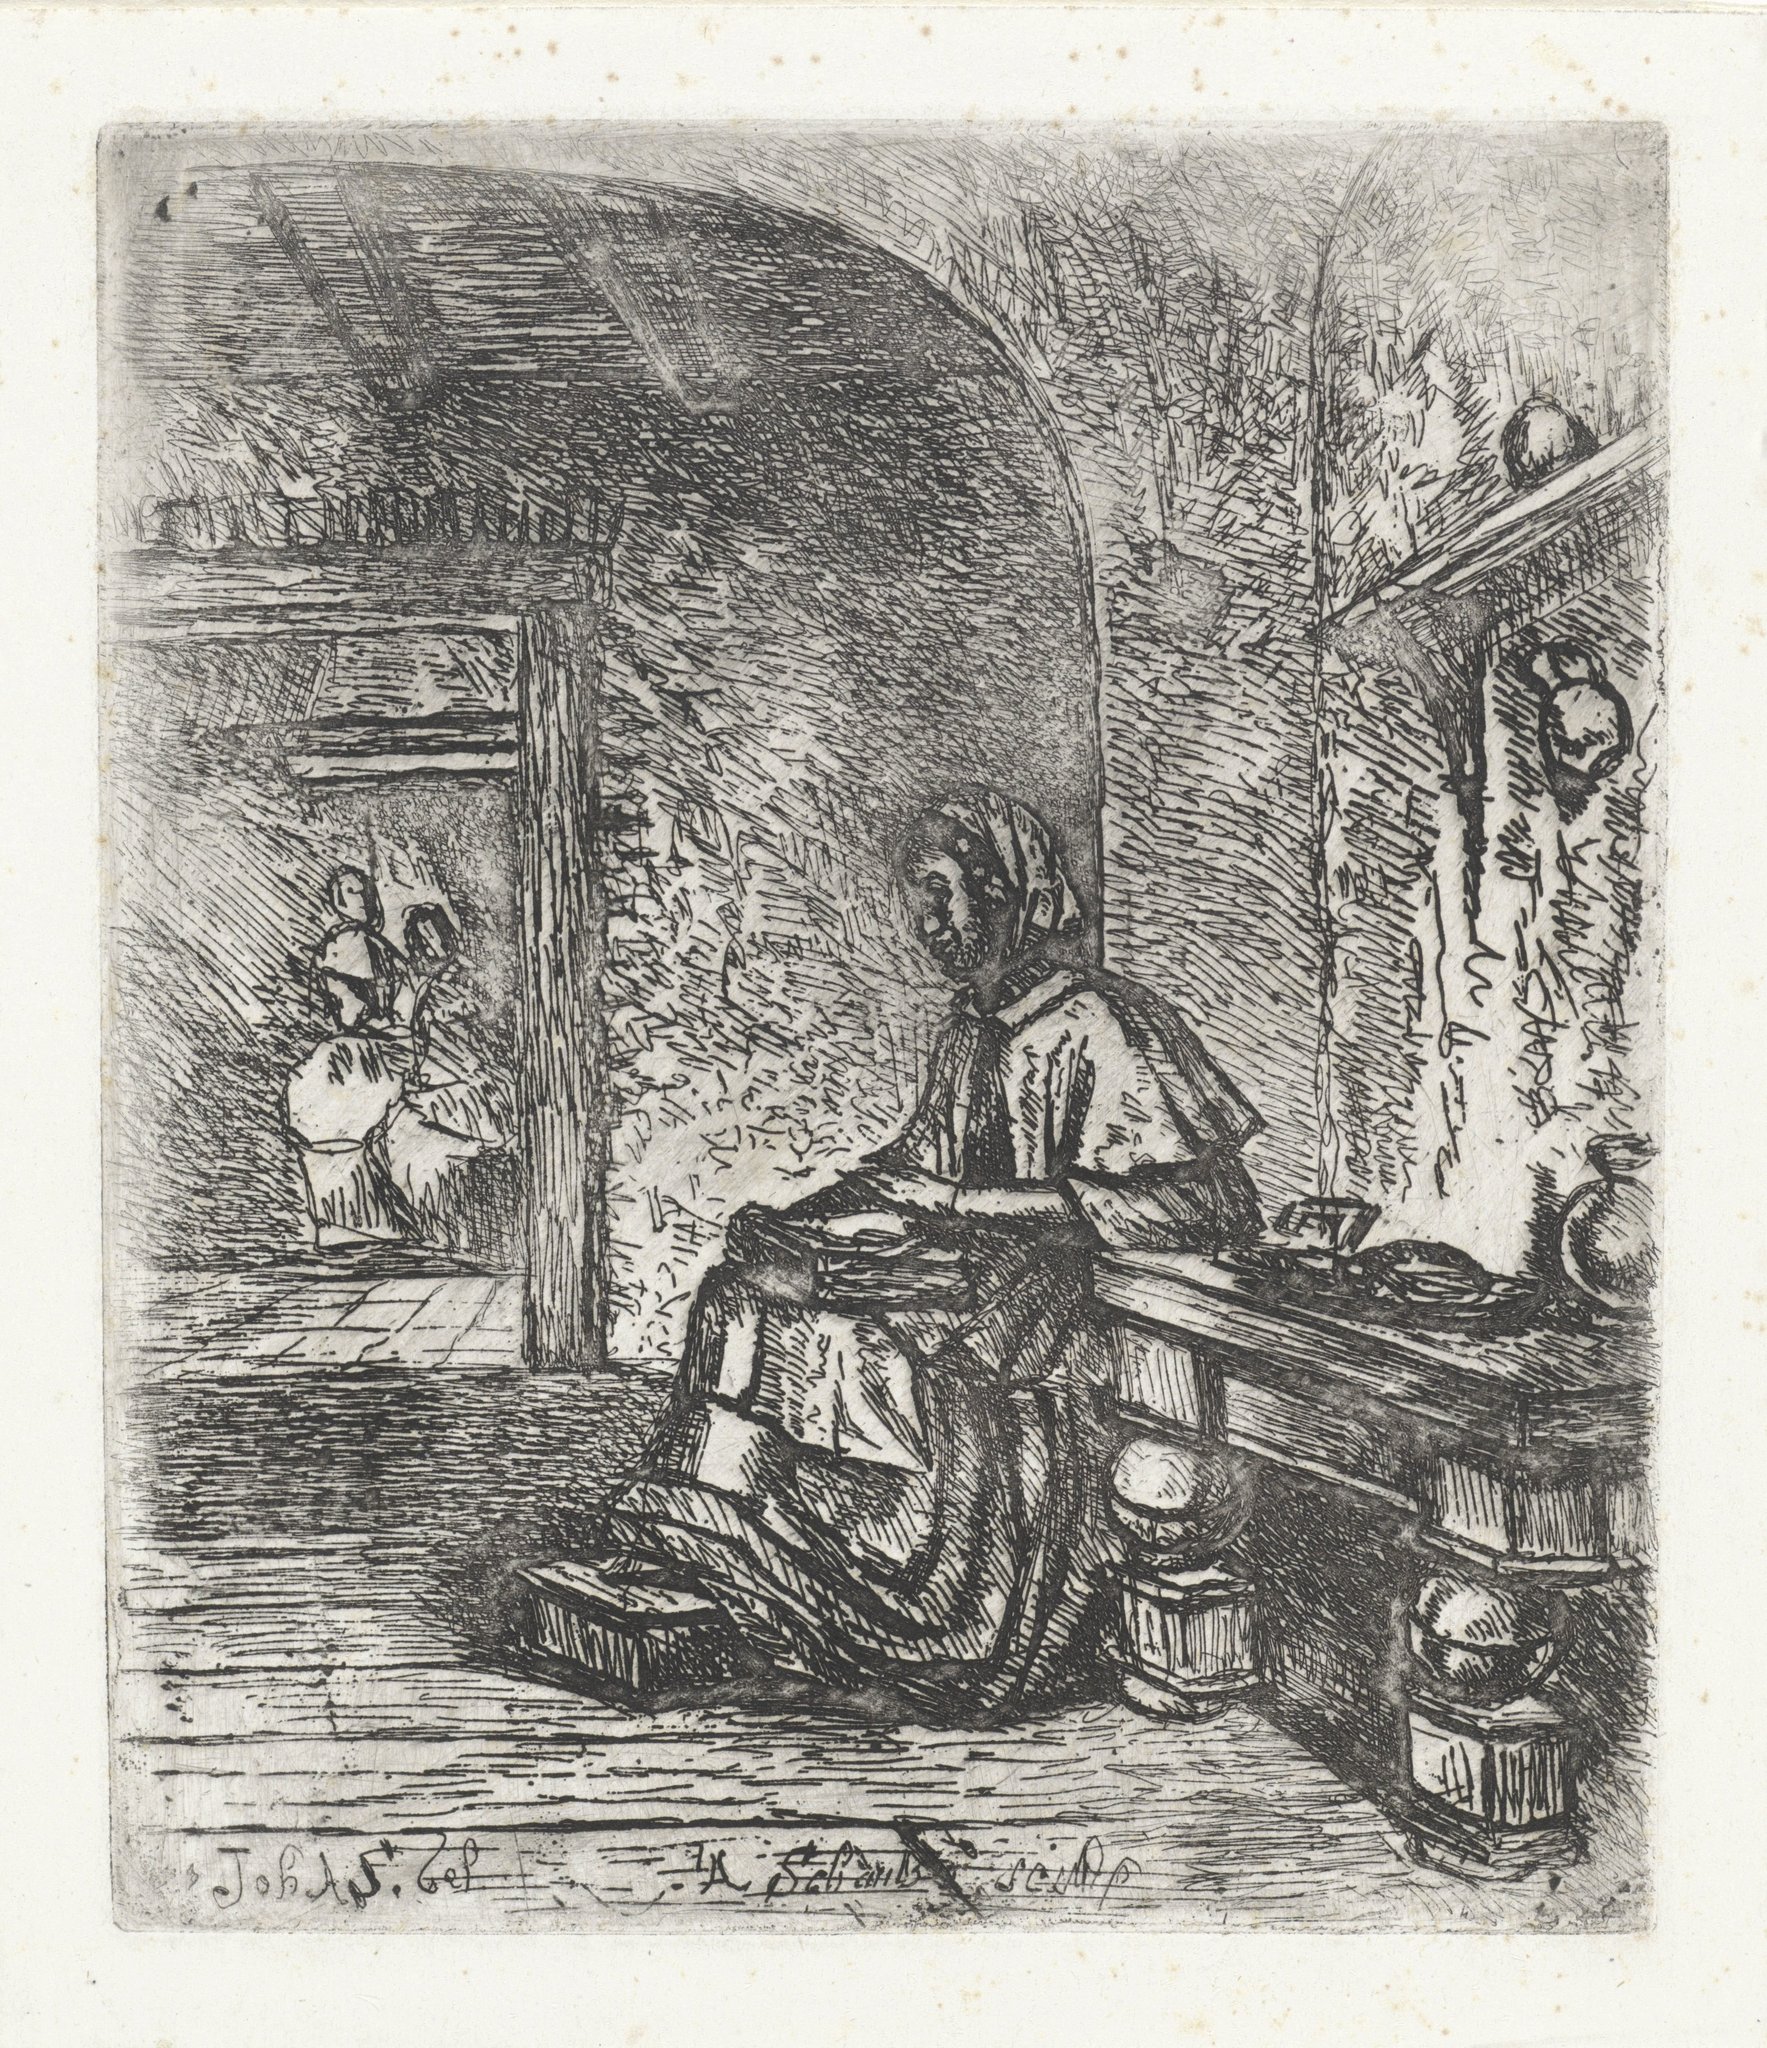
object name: print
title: Kantwerkster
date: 1830-1863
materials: paper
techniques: etching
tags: sitting figure - aa - female human figure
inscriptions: collector's mark: Lugt 2228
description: In een interieur is een vrouw aan het handwerken. Ze zit met haar voeten op een stoof. Naast haar een tafel.